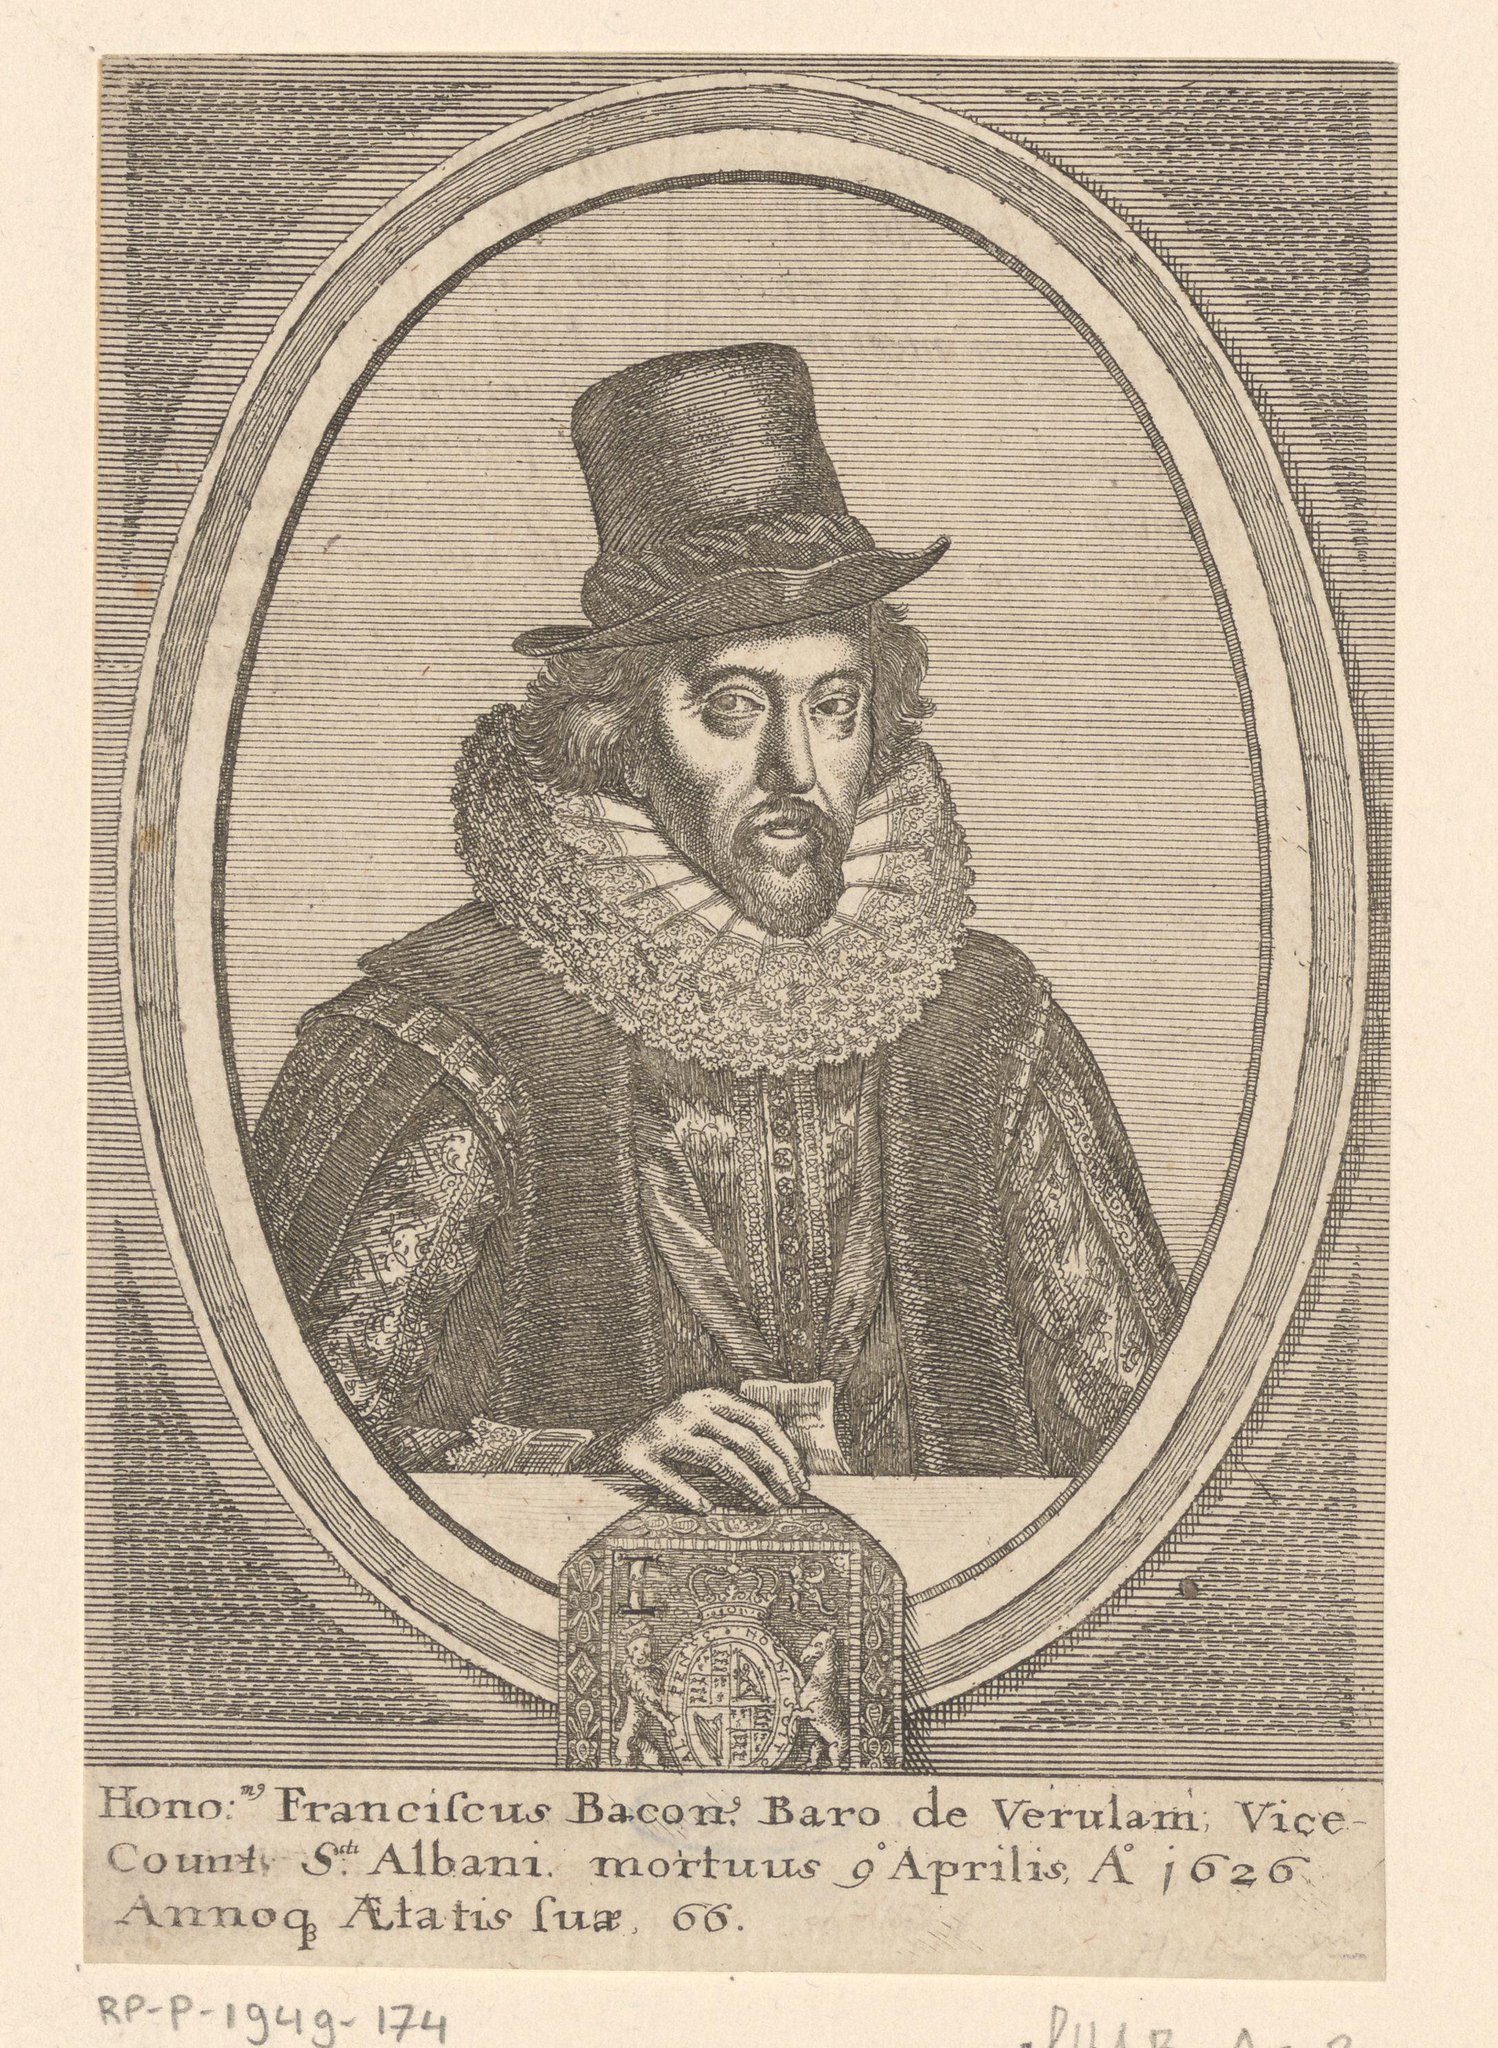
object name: book illustration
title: Portret van Francis Bacon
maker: wenceslaus hollar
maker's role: draughtsman, print maker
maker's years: 1607-1677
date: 1676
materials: paper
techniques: etching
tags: london, historical persons, armorial bearing, heraldry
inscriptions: collector's mark: Lugt 2228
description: Prent uit: Bacon, Francis. The history of the reign of Henry VII (...). London: s.n., 1676.